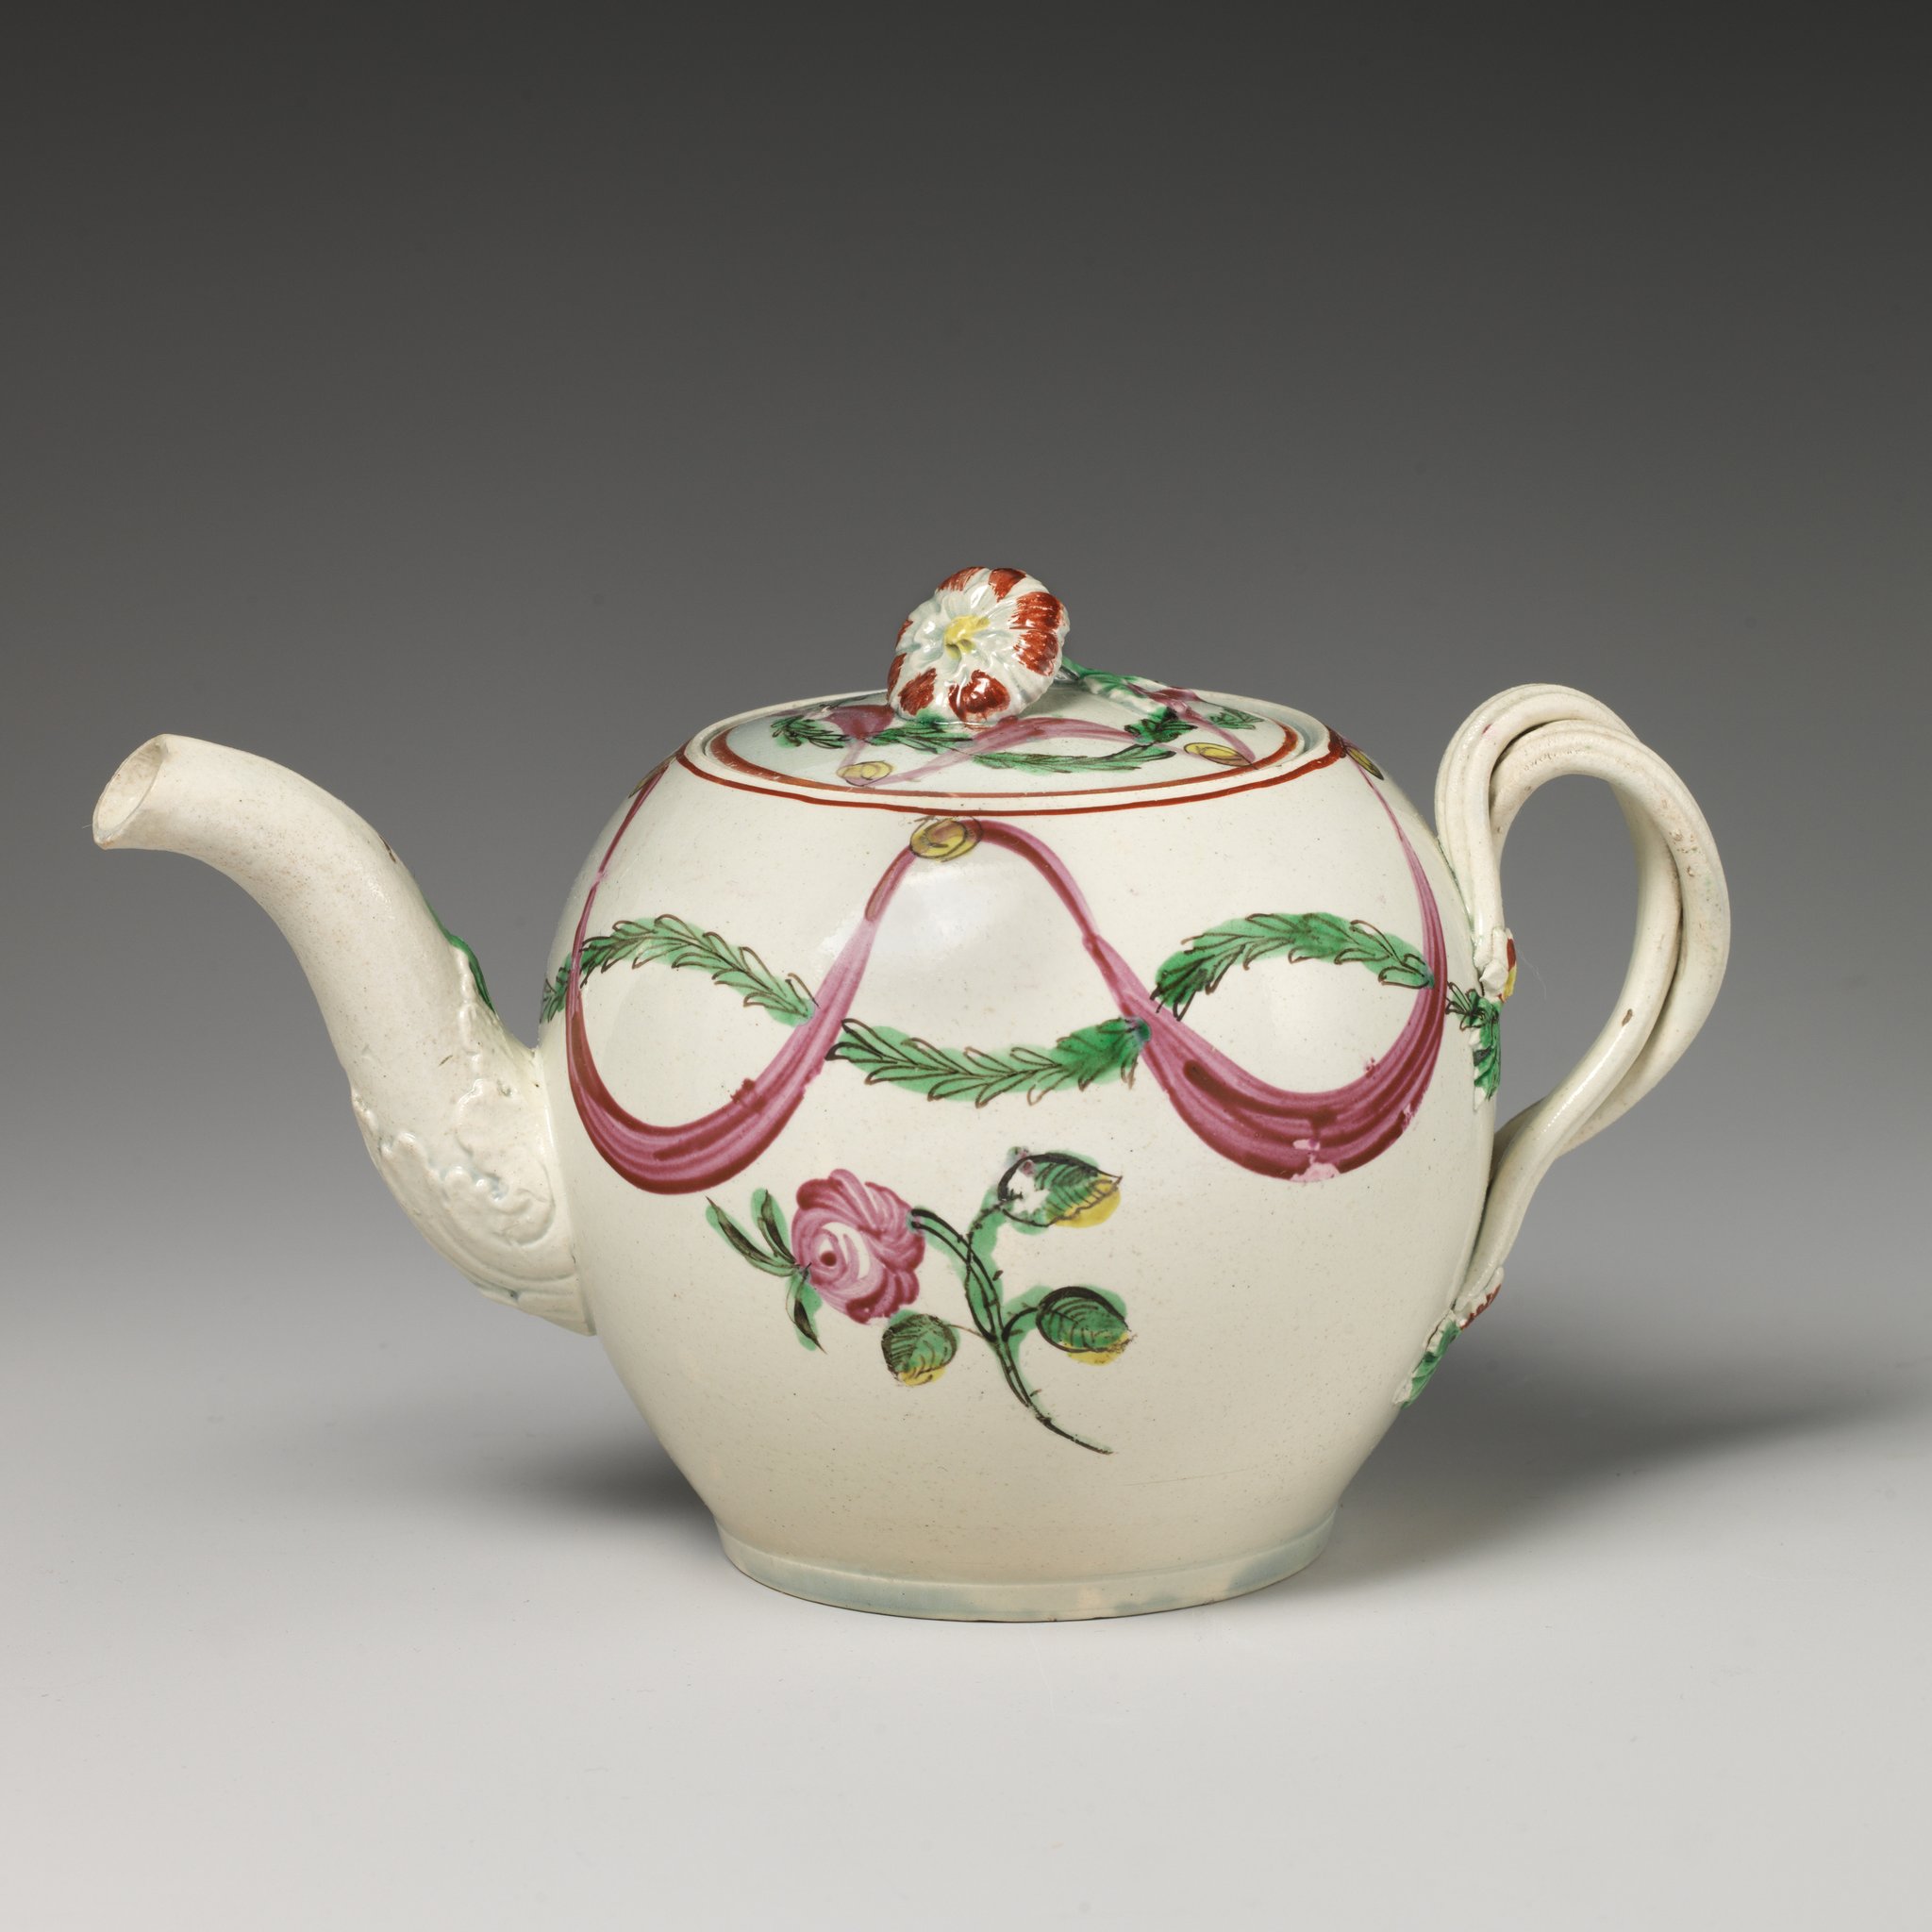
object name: teapot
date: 1780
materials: enamel, stoneware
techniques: salt glaze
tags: flowers,leaves